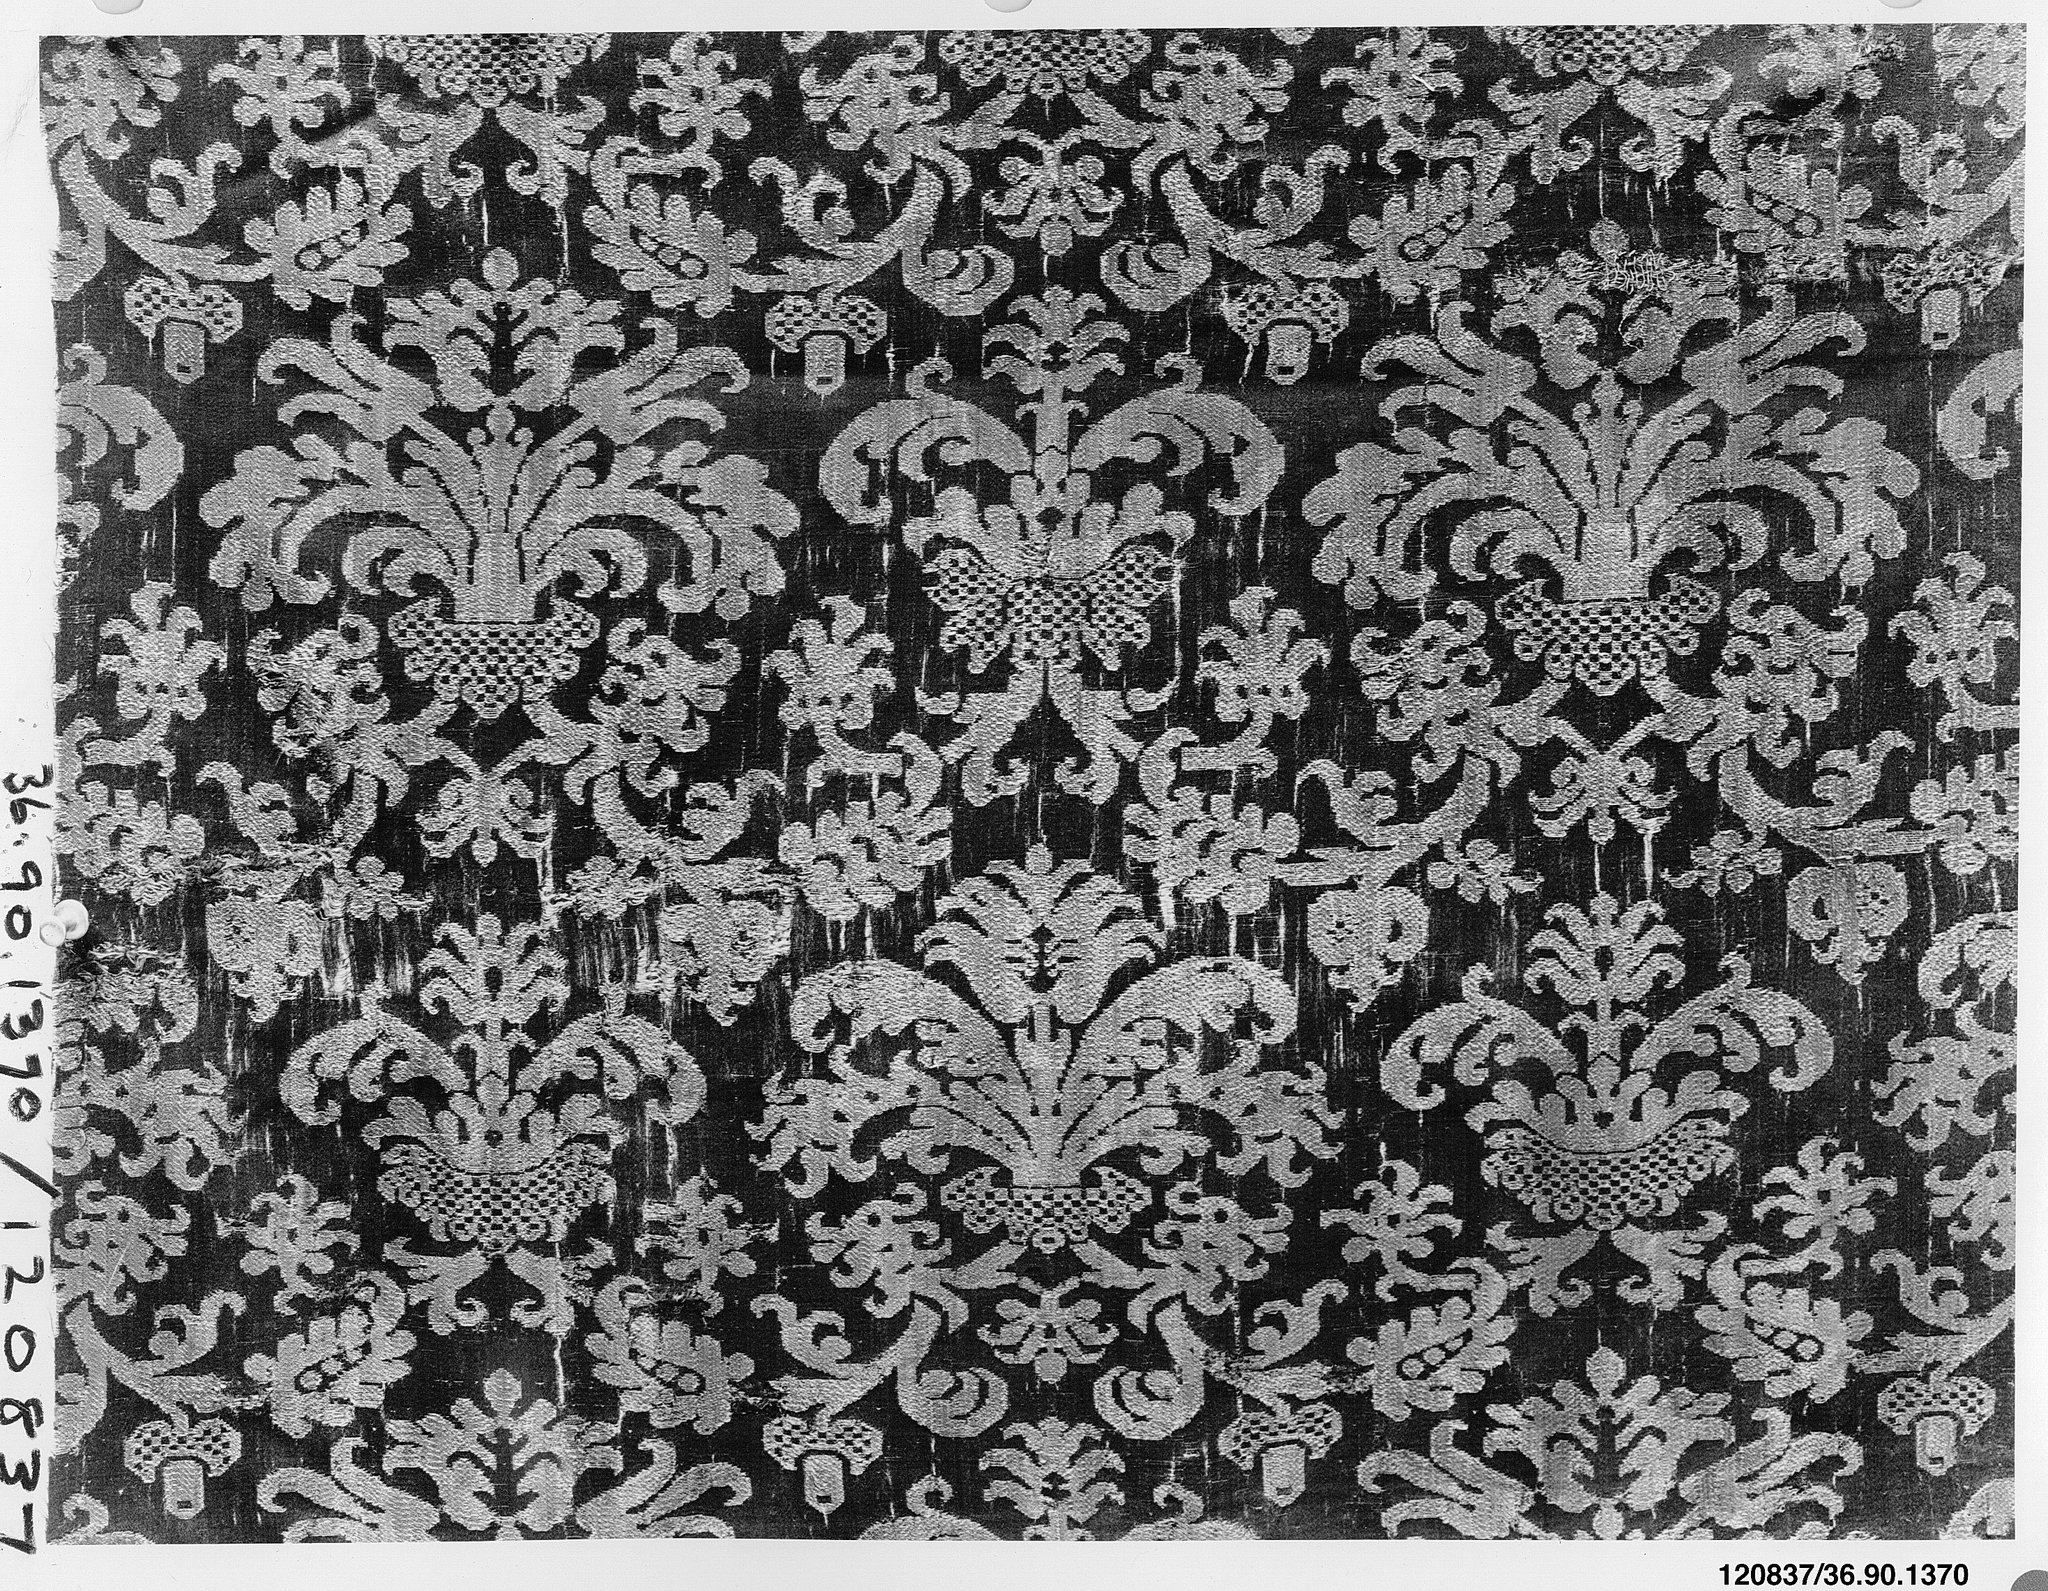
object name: piece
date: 1501-1600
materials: silk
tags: flowers,leaves